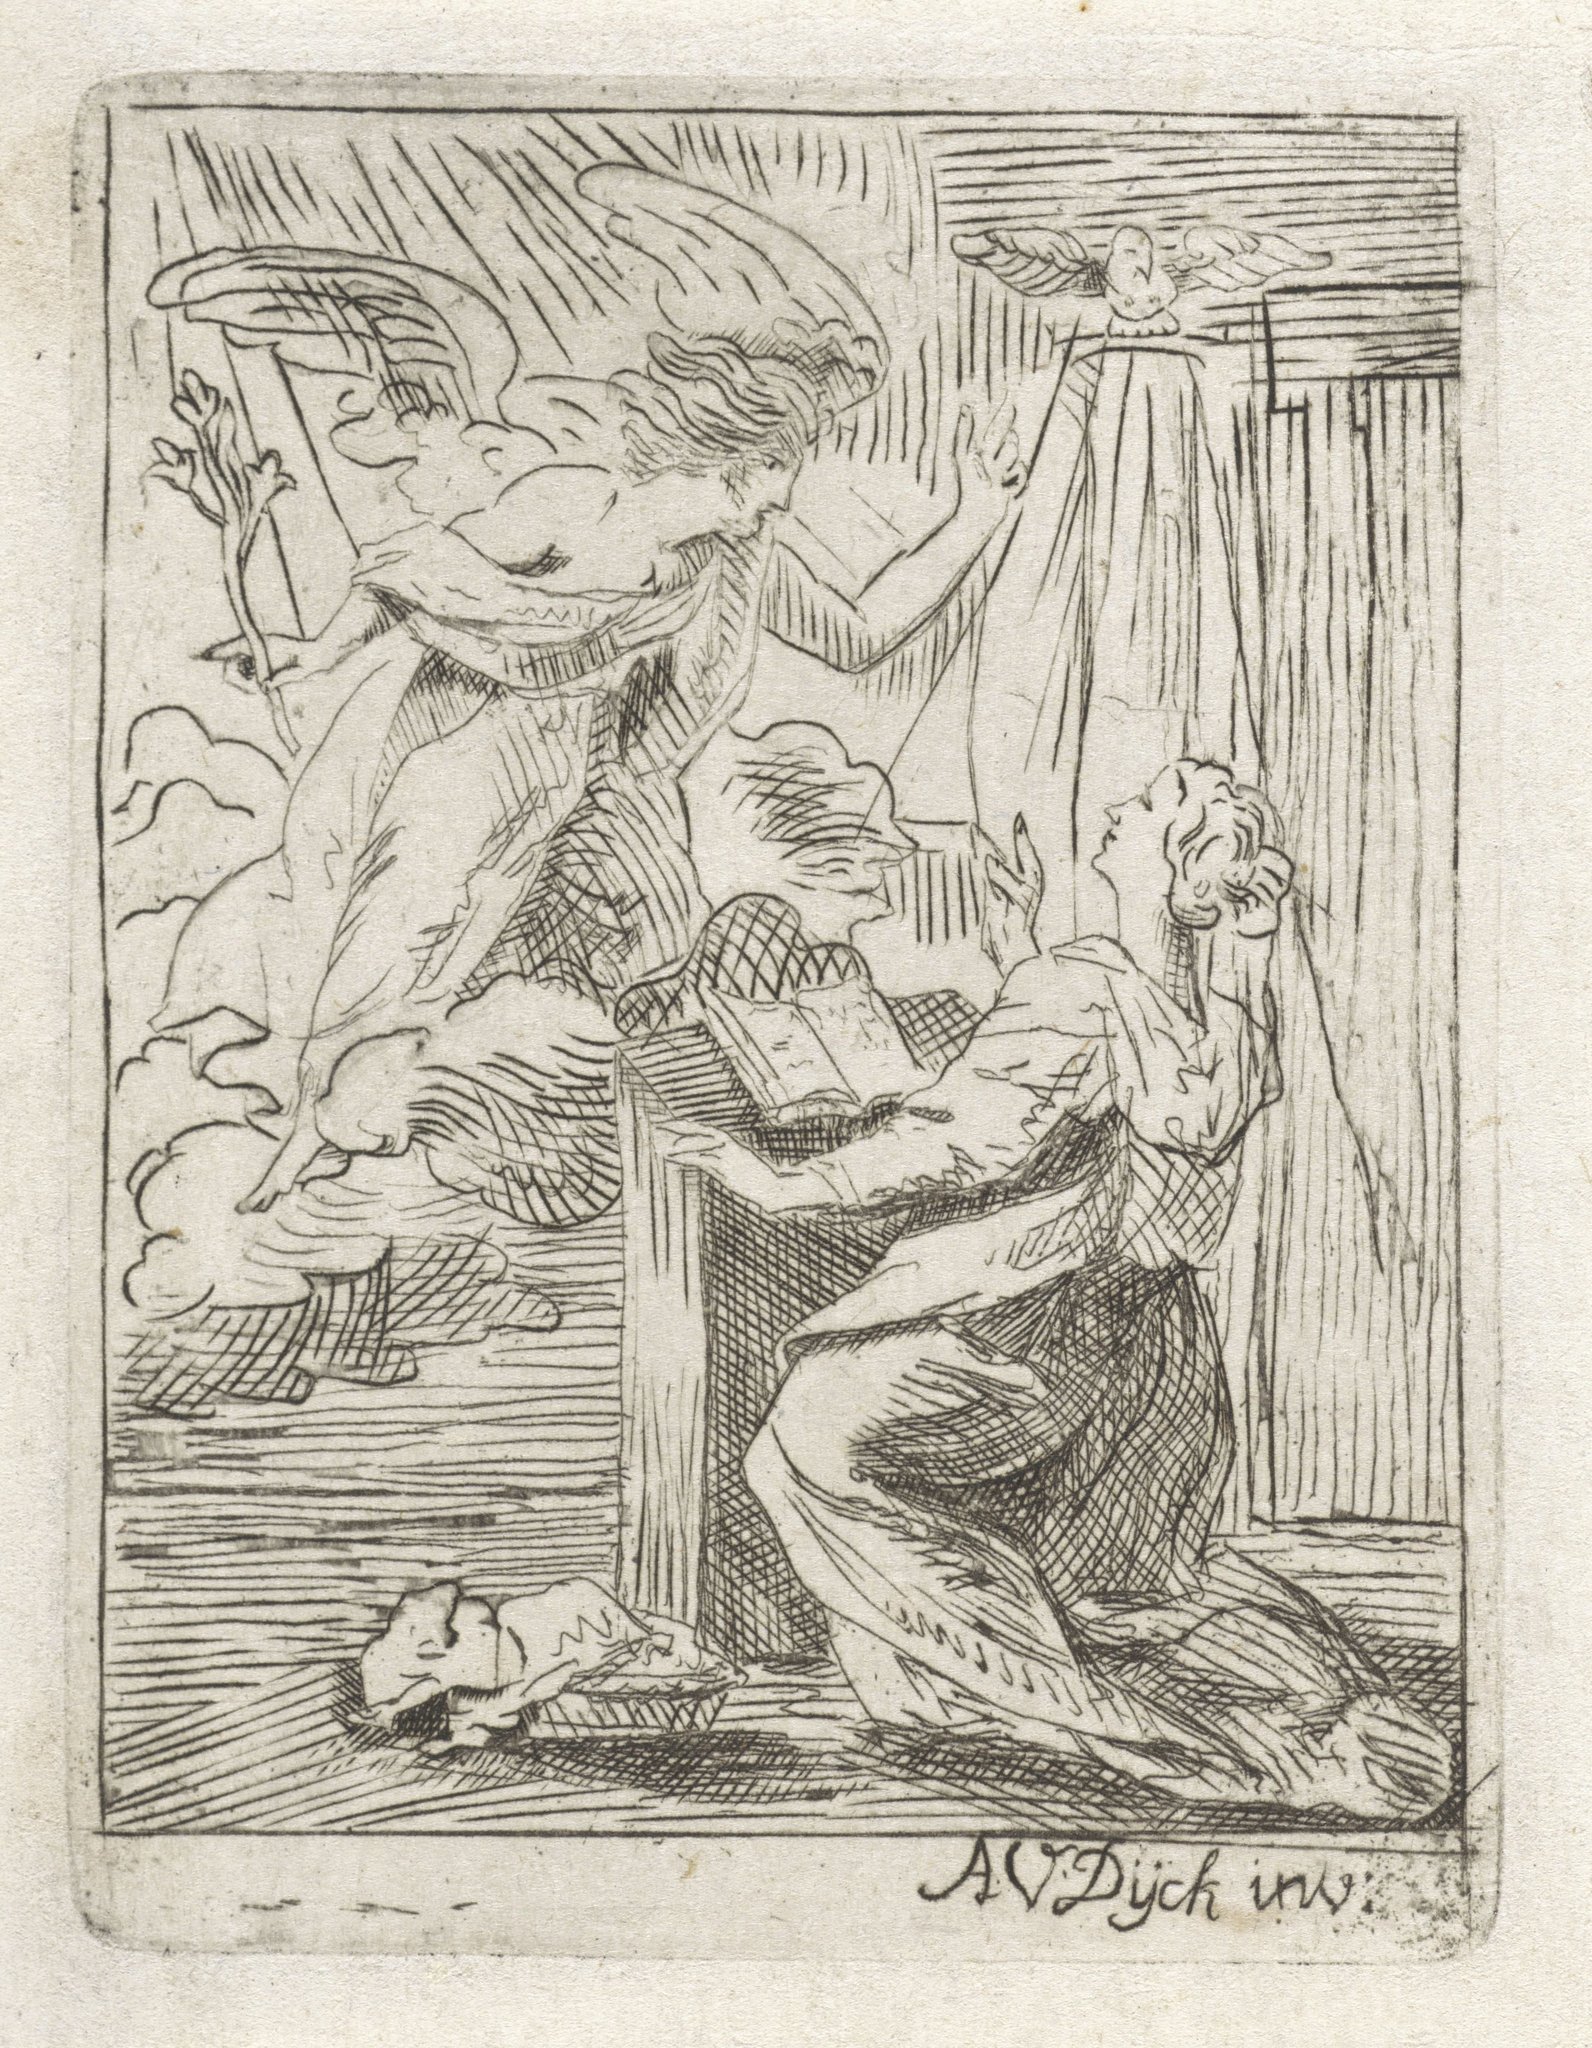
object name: print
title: Annunciatie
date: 1615-1691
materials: paper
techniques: etching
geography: low countries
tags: the annunciation: mary kneeling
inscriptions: collector's mark: Lugt 240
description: De aartsengel Gabriël verschijnt met een lelie aan Maria. Maria knielt bij een lessenaar met daarop een opengeslagen boek. Boven haar de Heilige Geest in de gedaante van een duif.